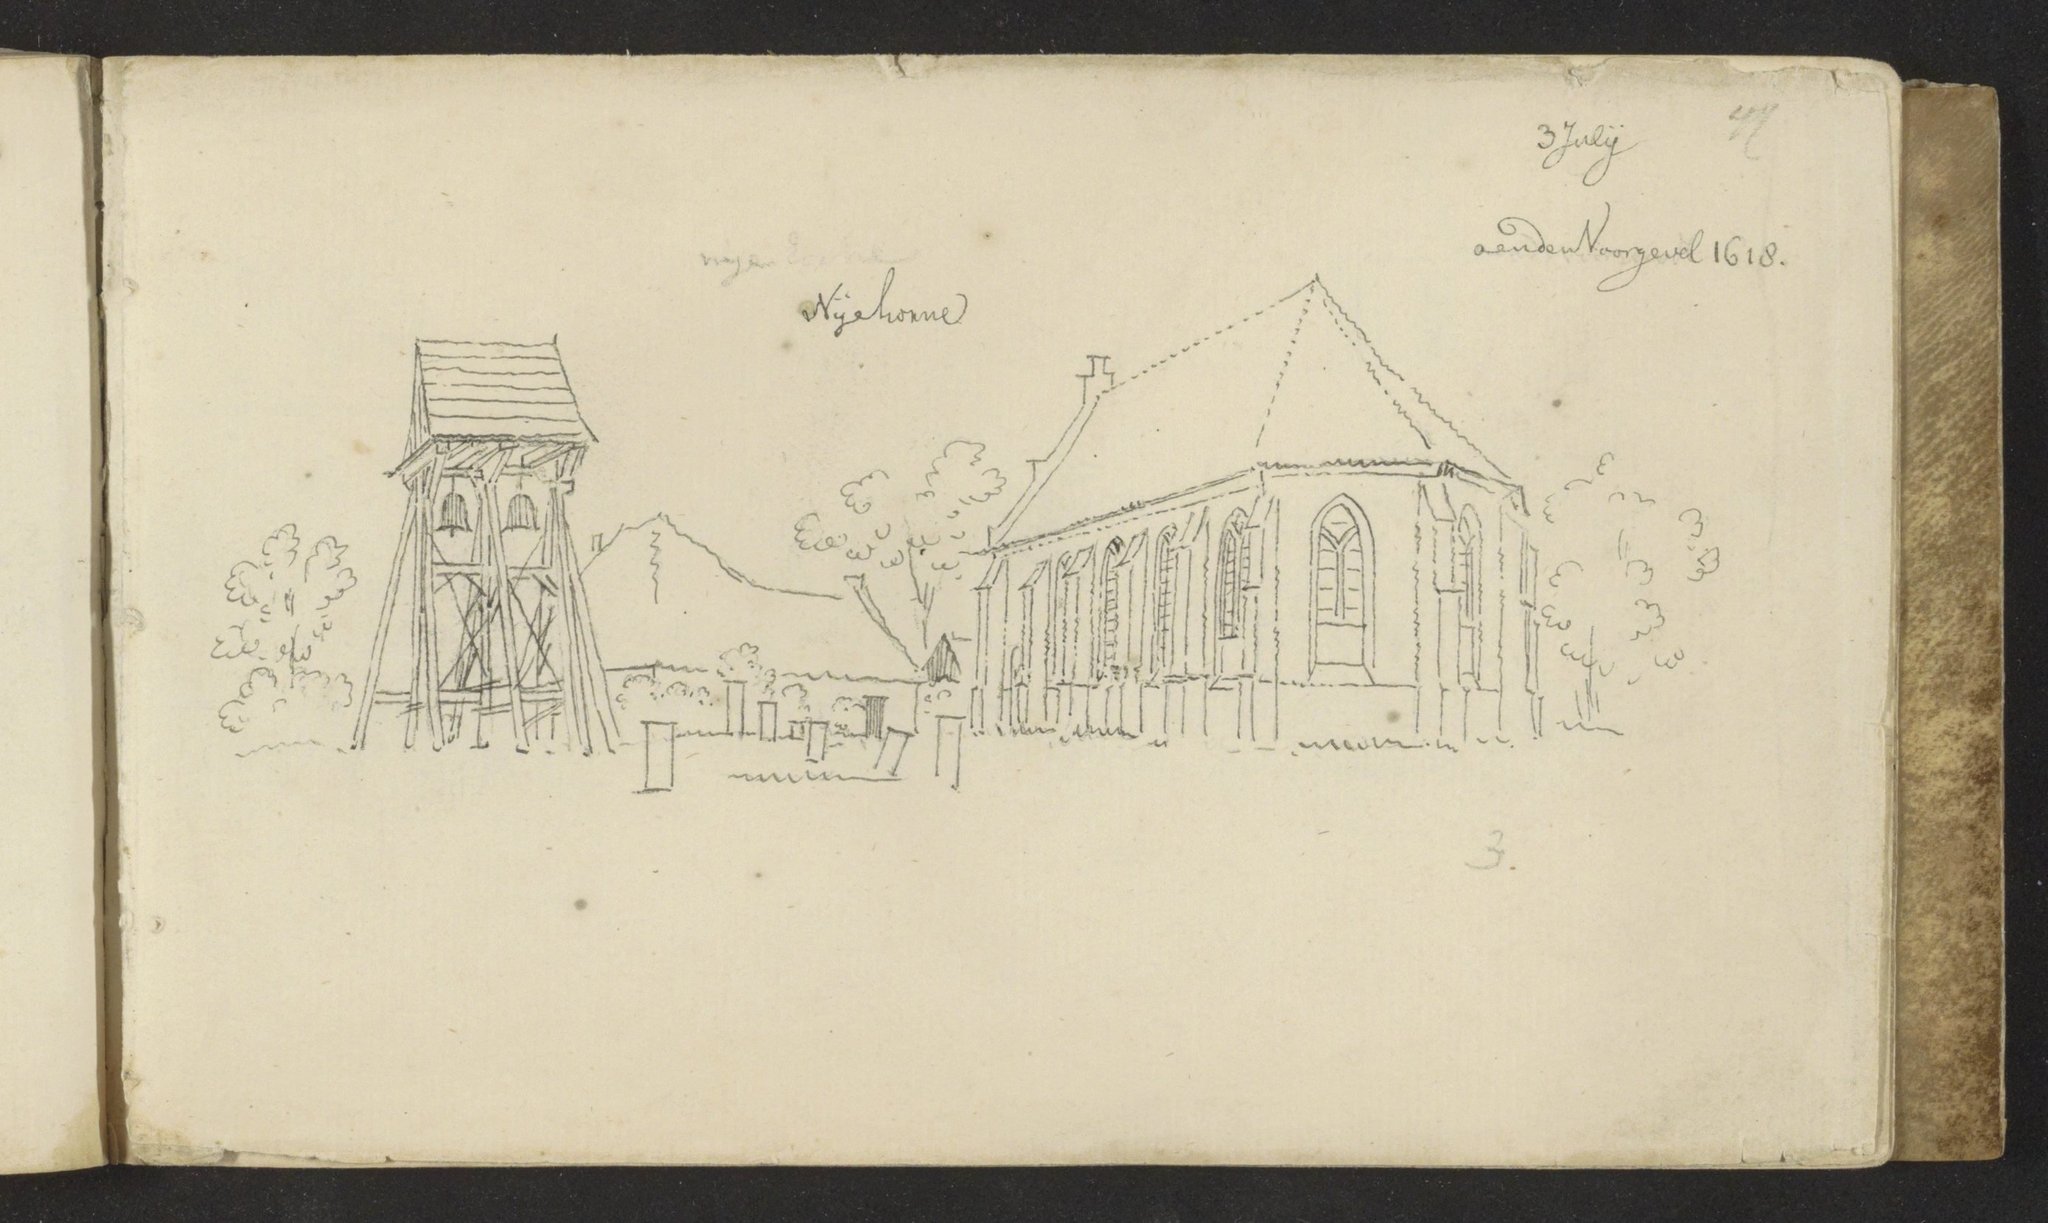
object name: sketchbook leaf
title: Kerk te Nieuwehorne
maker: abraham de haen (ii)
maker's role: draughtsman, print maker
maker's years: 1707-1748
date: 1732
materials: ink, paper, pencil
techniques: pen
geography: nieuwehorne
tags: church (exterior)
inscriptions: date and inscription: ‘Nijehorne/ 3 Julij/ aande Noorgevel 1618’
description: Blad 47 recto uit een schetsboek met 51 bladen.